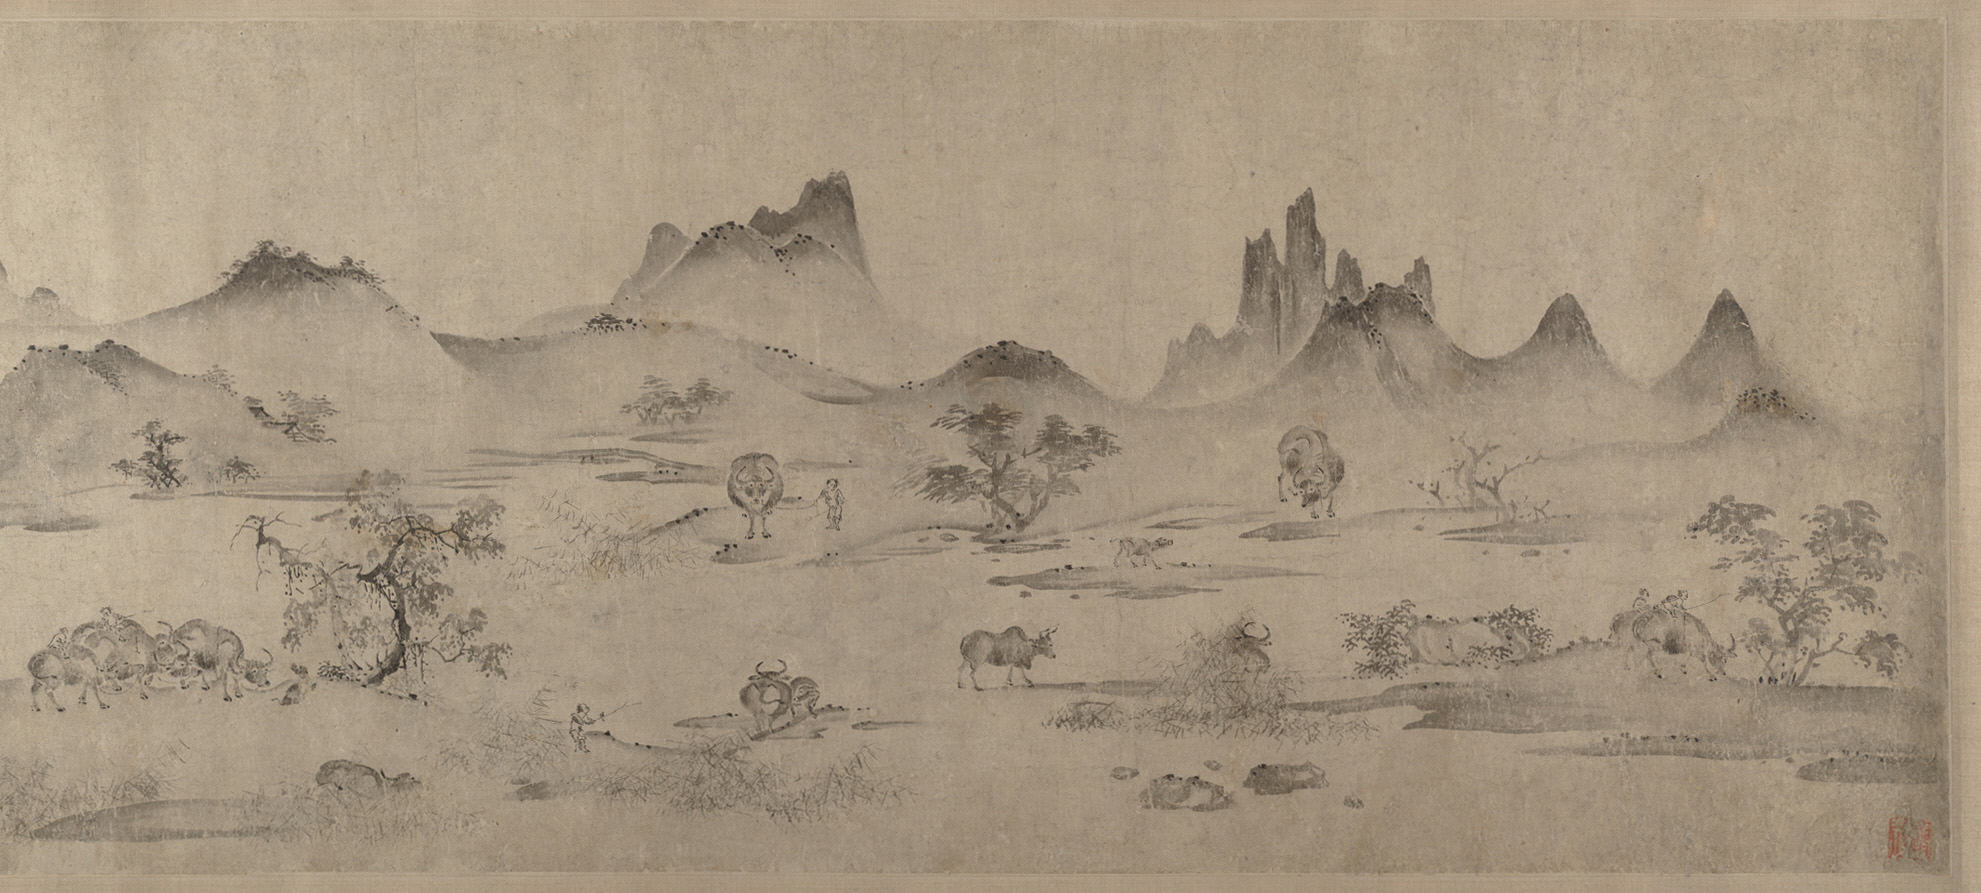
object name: handscroll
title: One hundred water buffalo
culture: chinese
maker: unidentified artist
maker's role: artist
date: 1201-1300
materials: ink, paper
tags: buffalos,landscapes